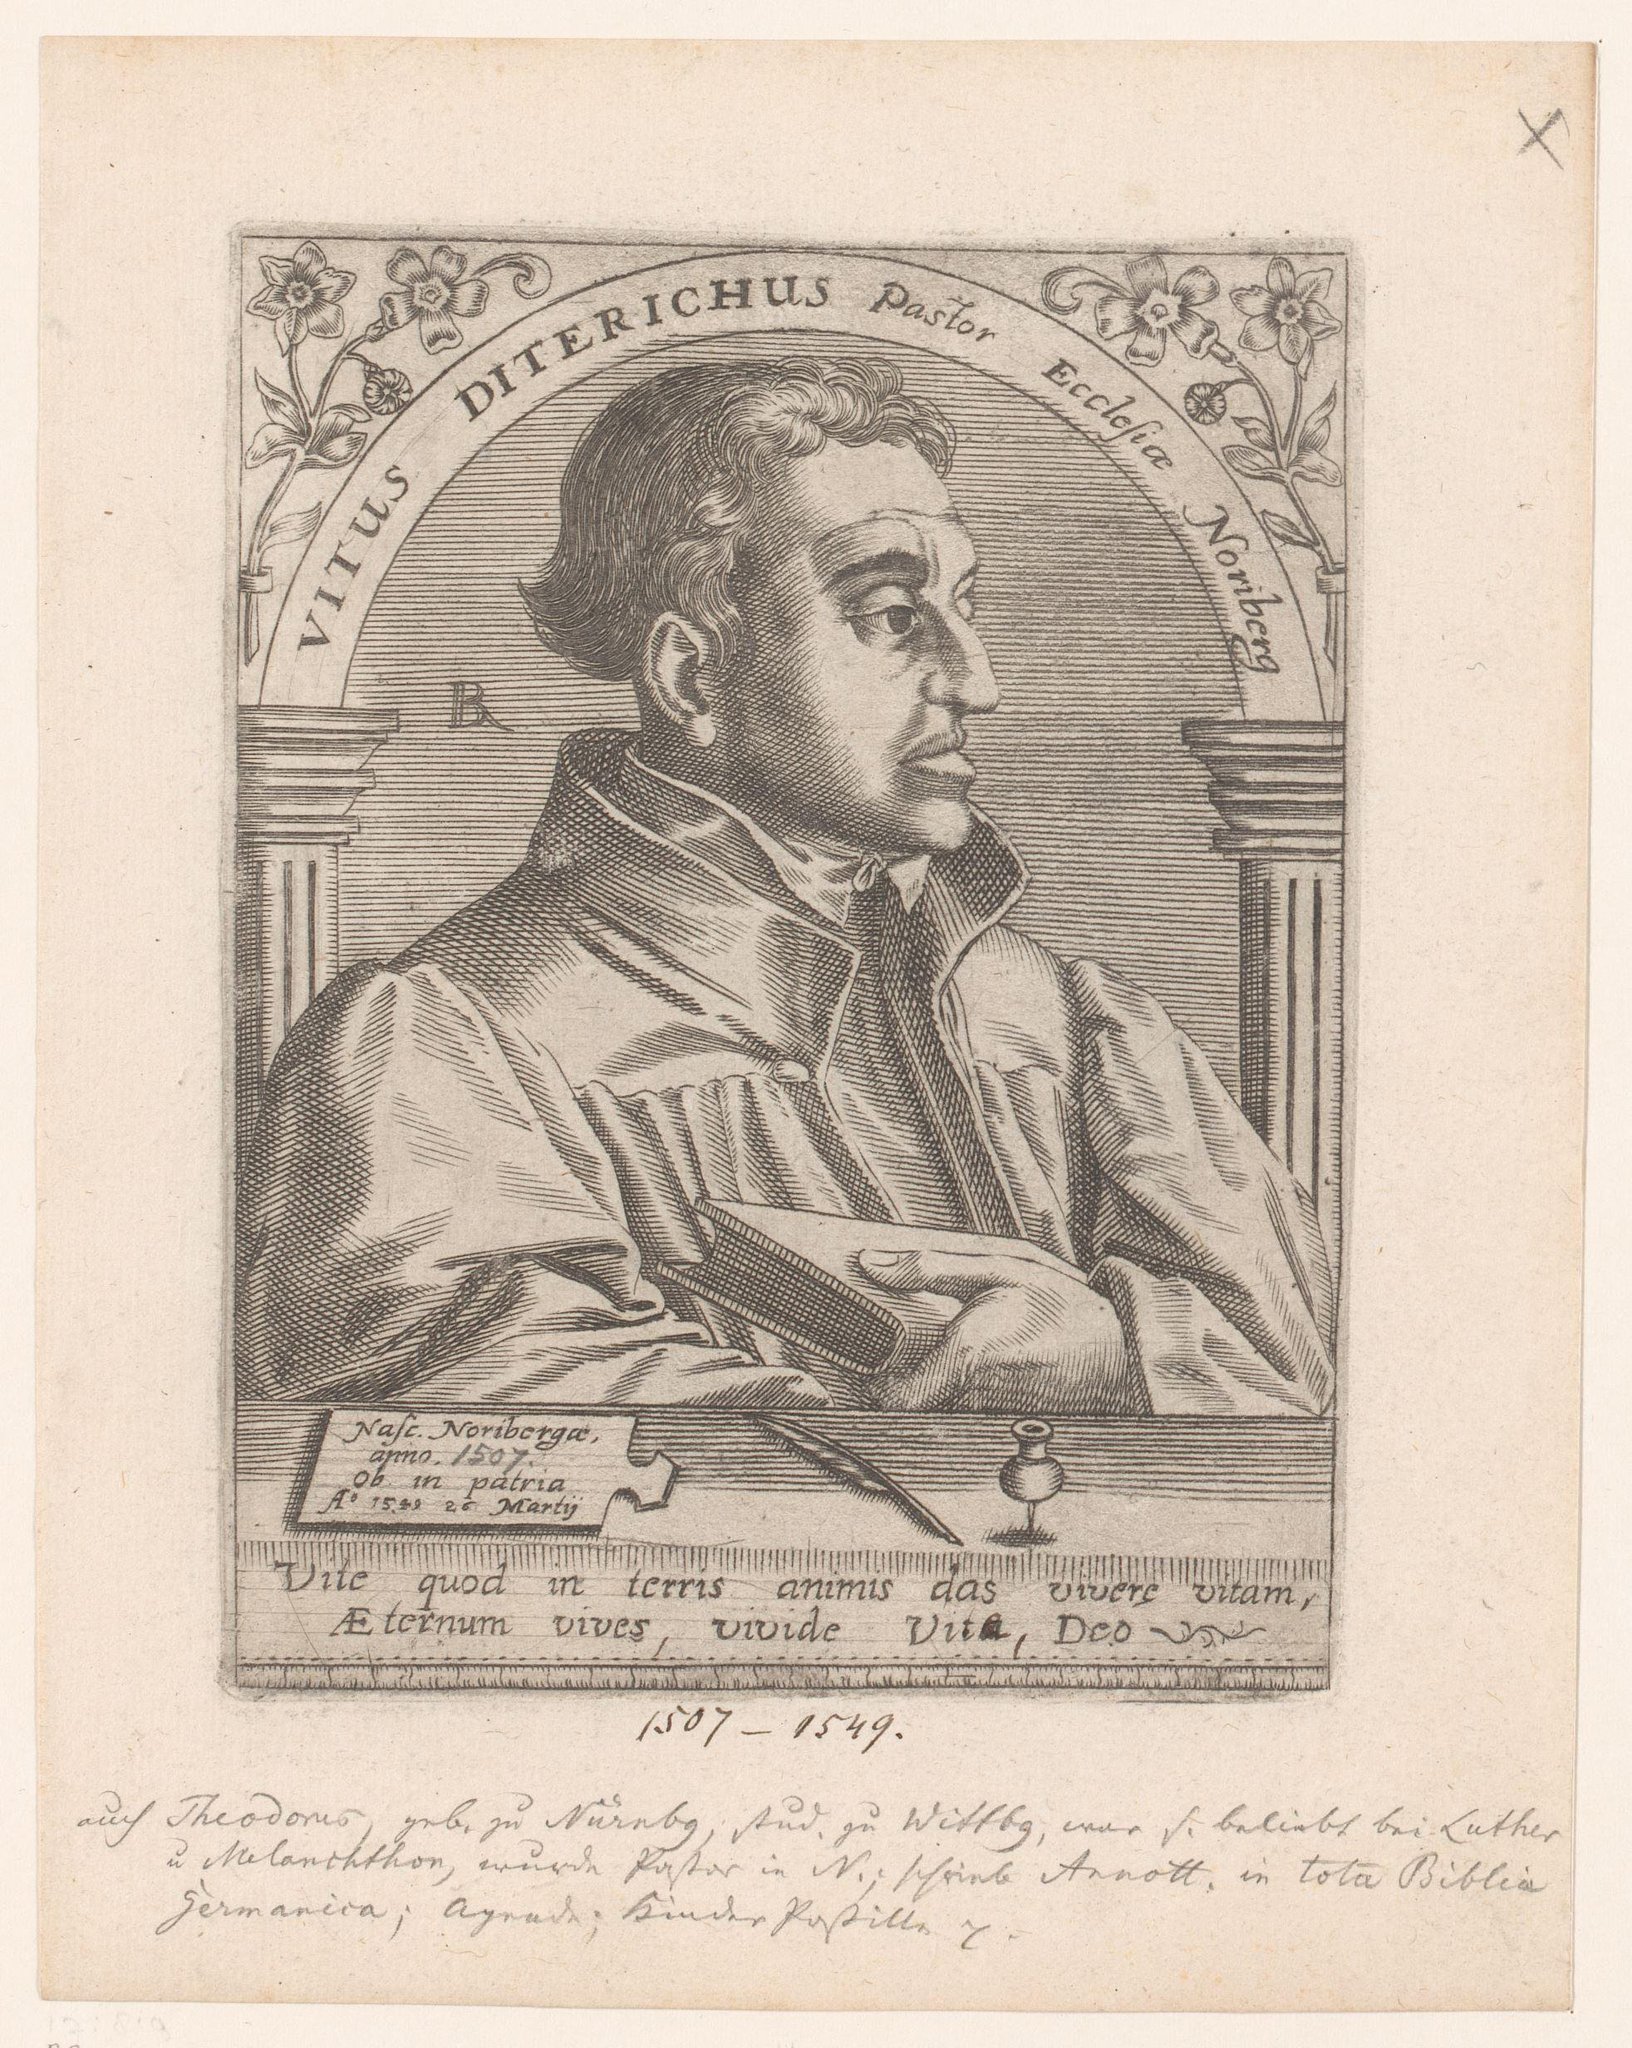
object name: print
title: Vitus Diterichus Pastor Ecclesia Noriberg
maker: robert boissard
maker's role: print maker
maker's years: 1570-1611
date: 1597-1599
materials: paper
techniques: engraving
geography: france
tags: ink-well, historical persons, book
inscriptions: inscription: ‘1507-1549.’, collector's mark: Lugt 2228